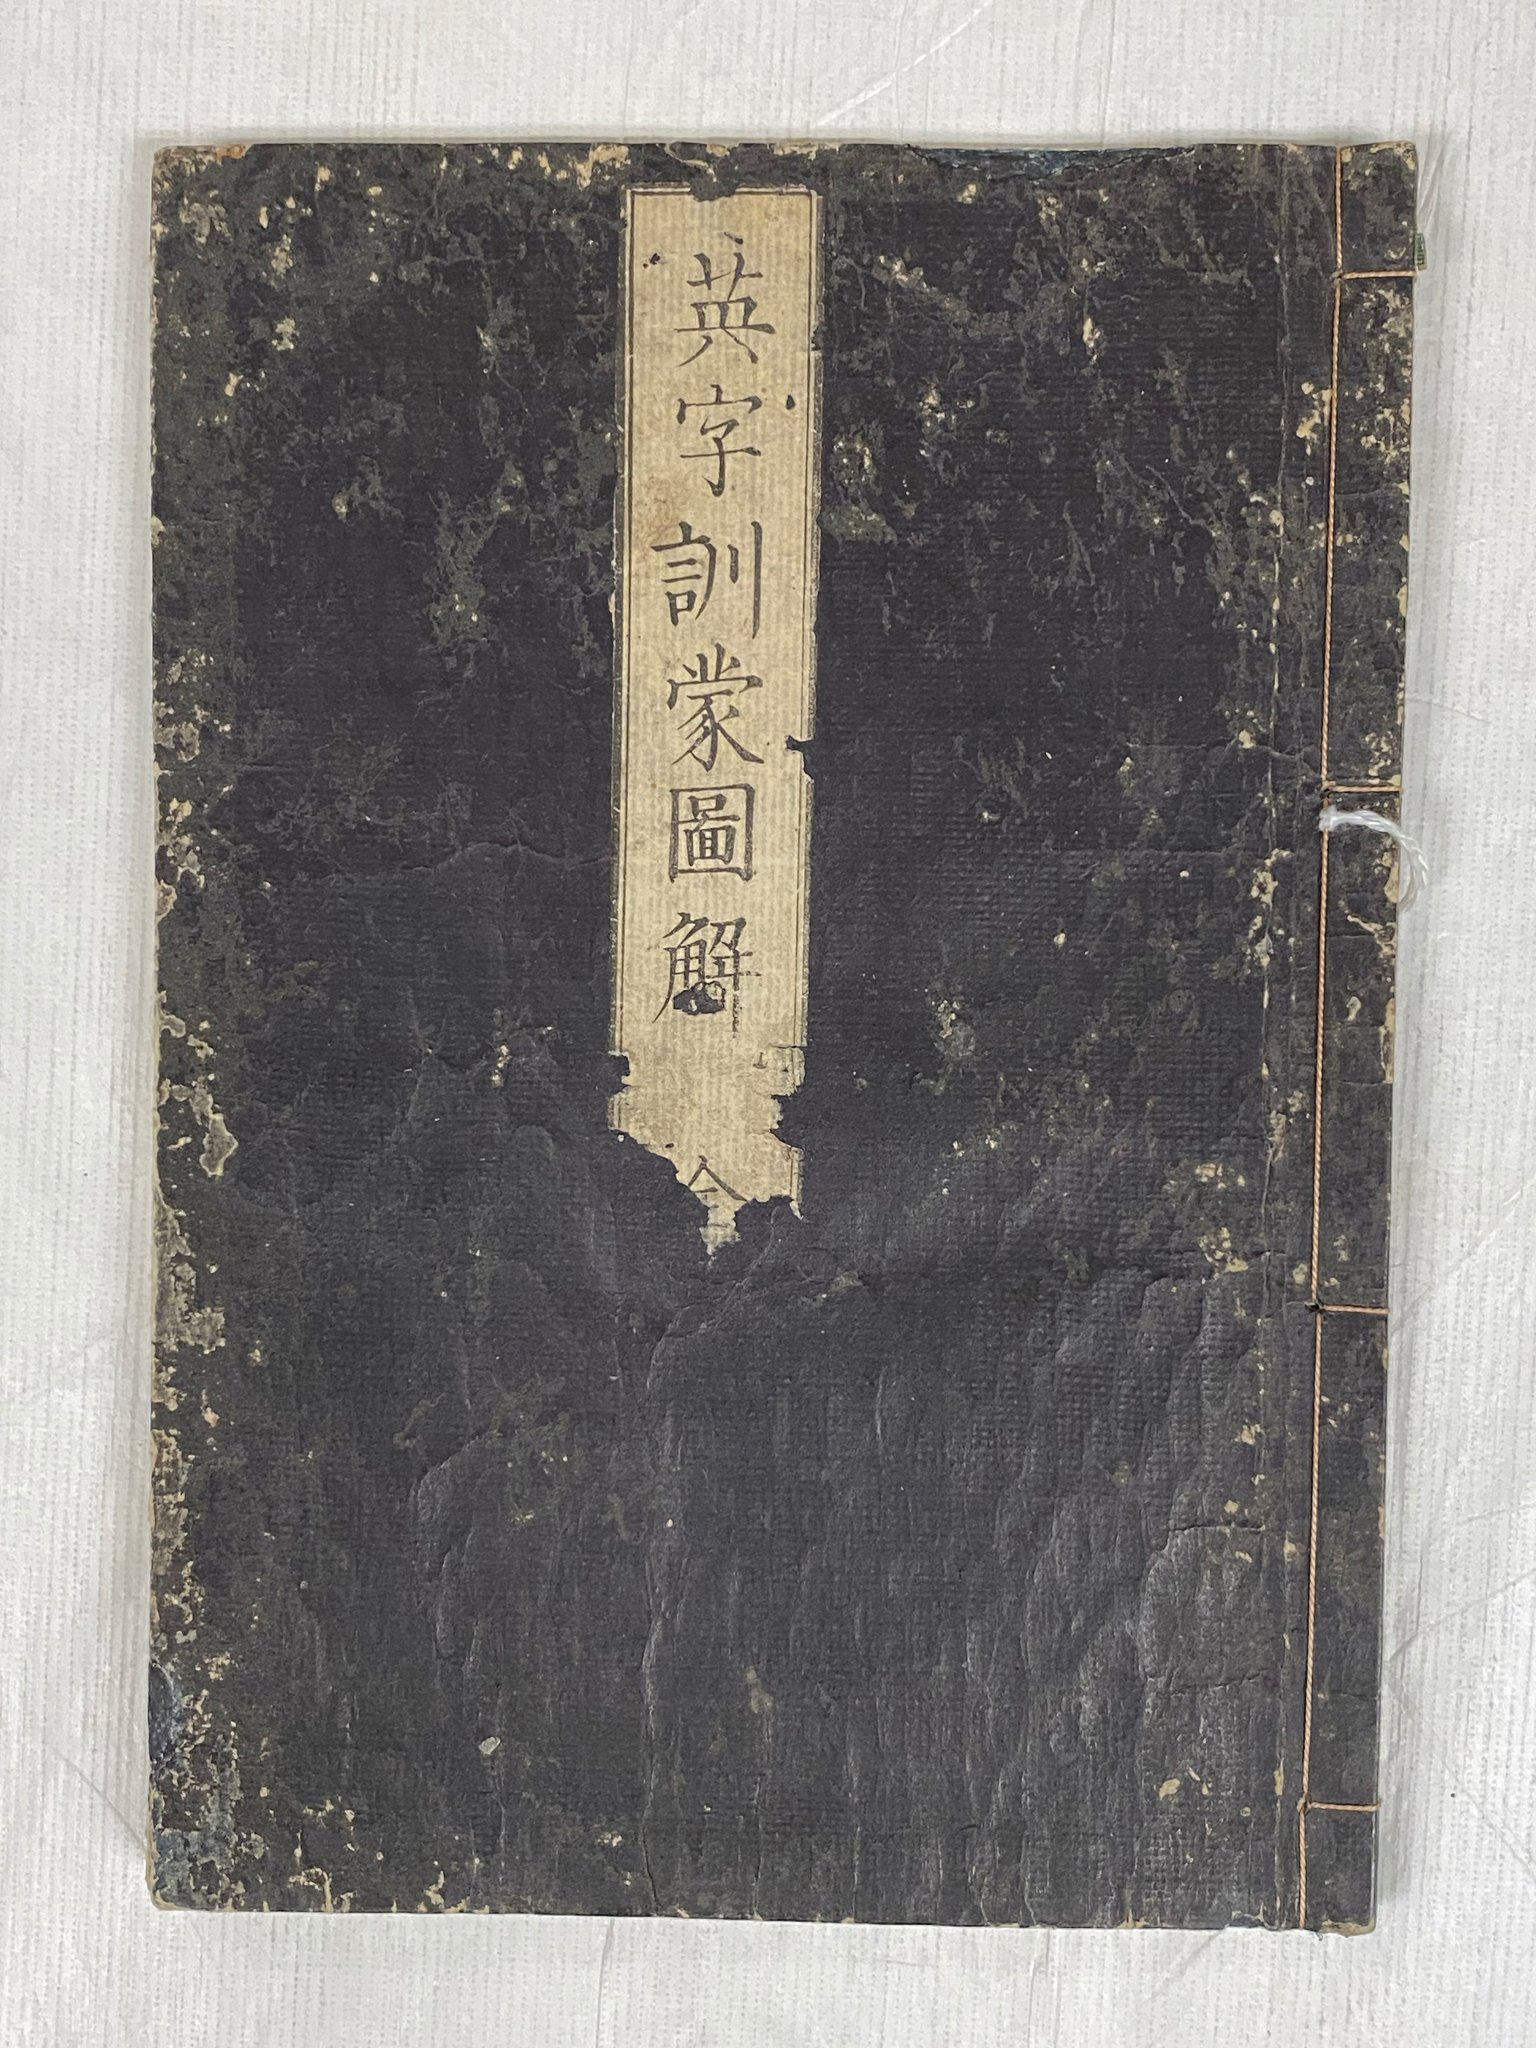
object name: illustrated book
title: Illustrated Manual of English Instruction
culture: japanese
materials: ink, paper